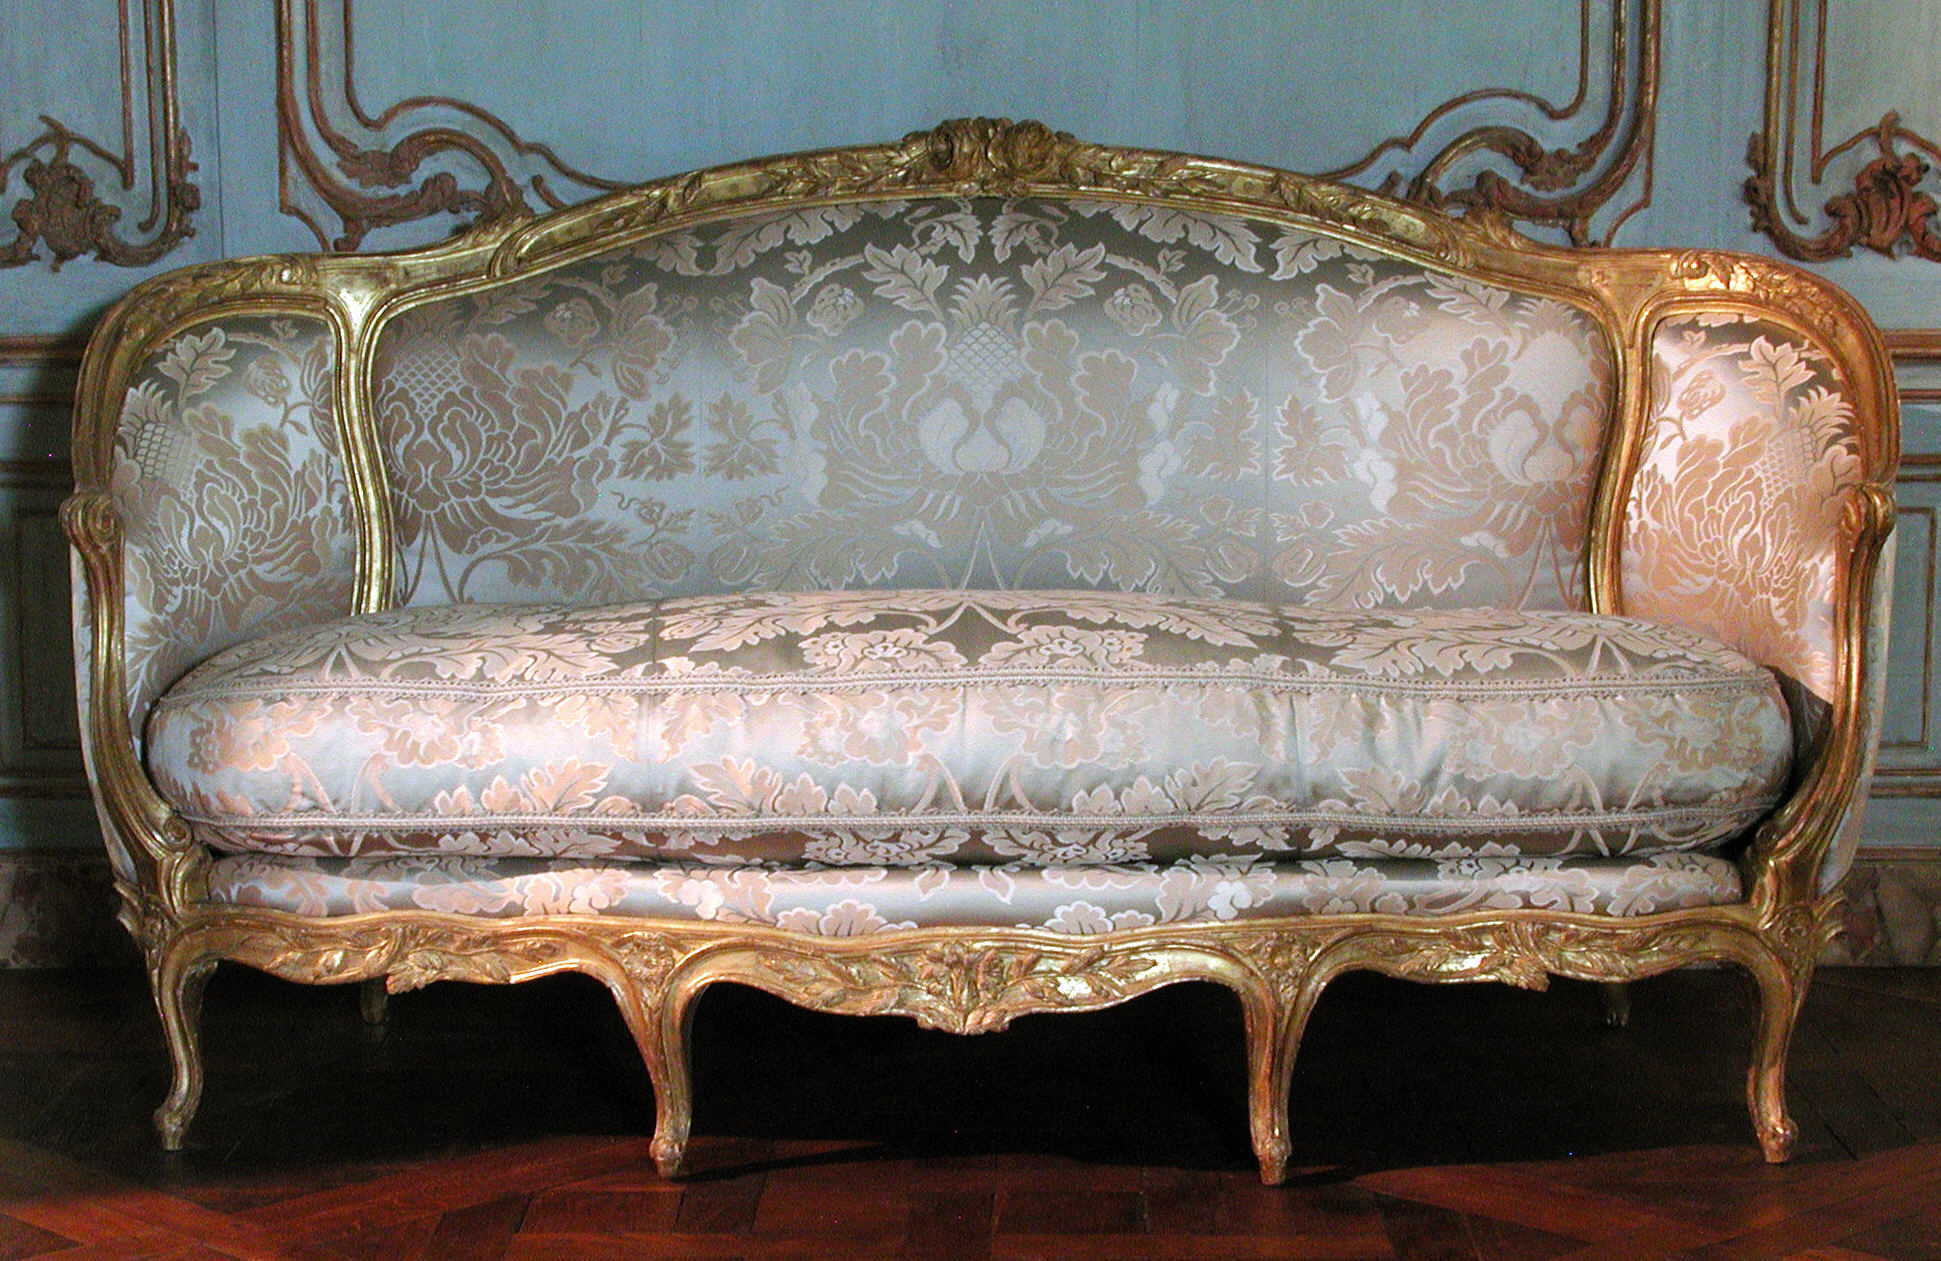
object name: sofa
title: Sofa (canapé à confidents)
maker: jean-jacques pothier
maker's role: maker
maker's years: 1750-1780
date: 1765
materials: wood, silk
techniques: carving, gilding, lampas